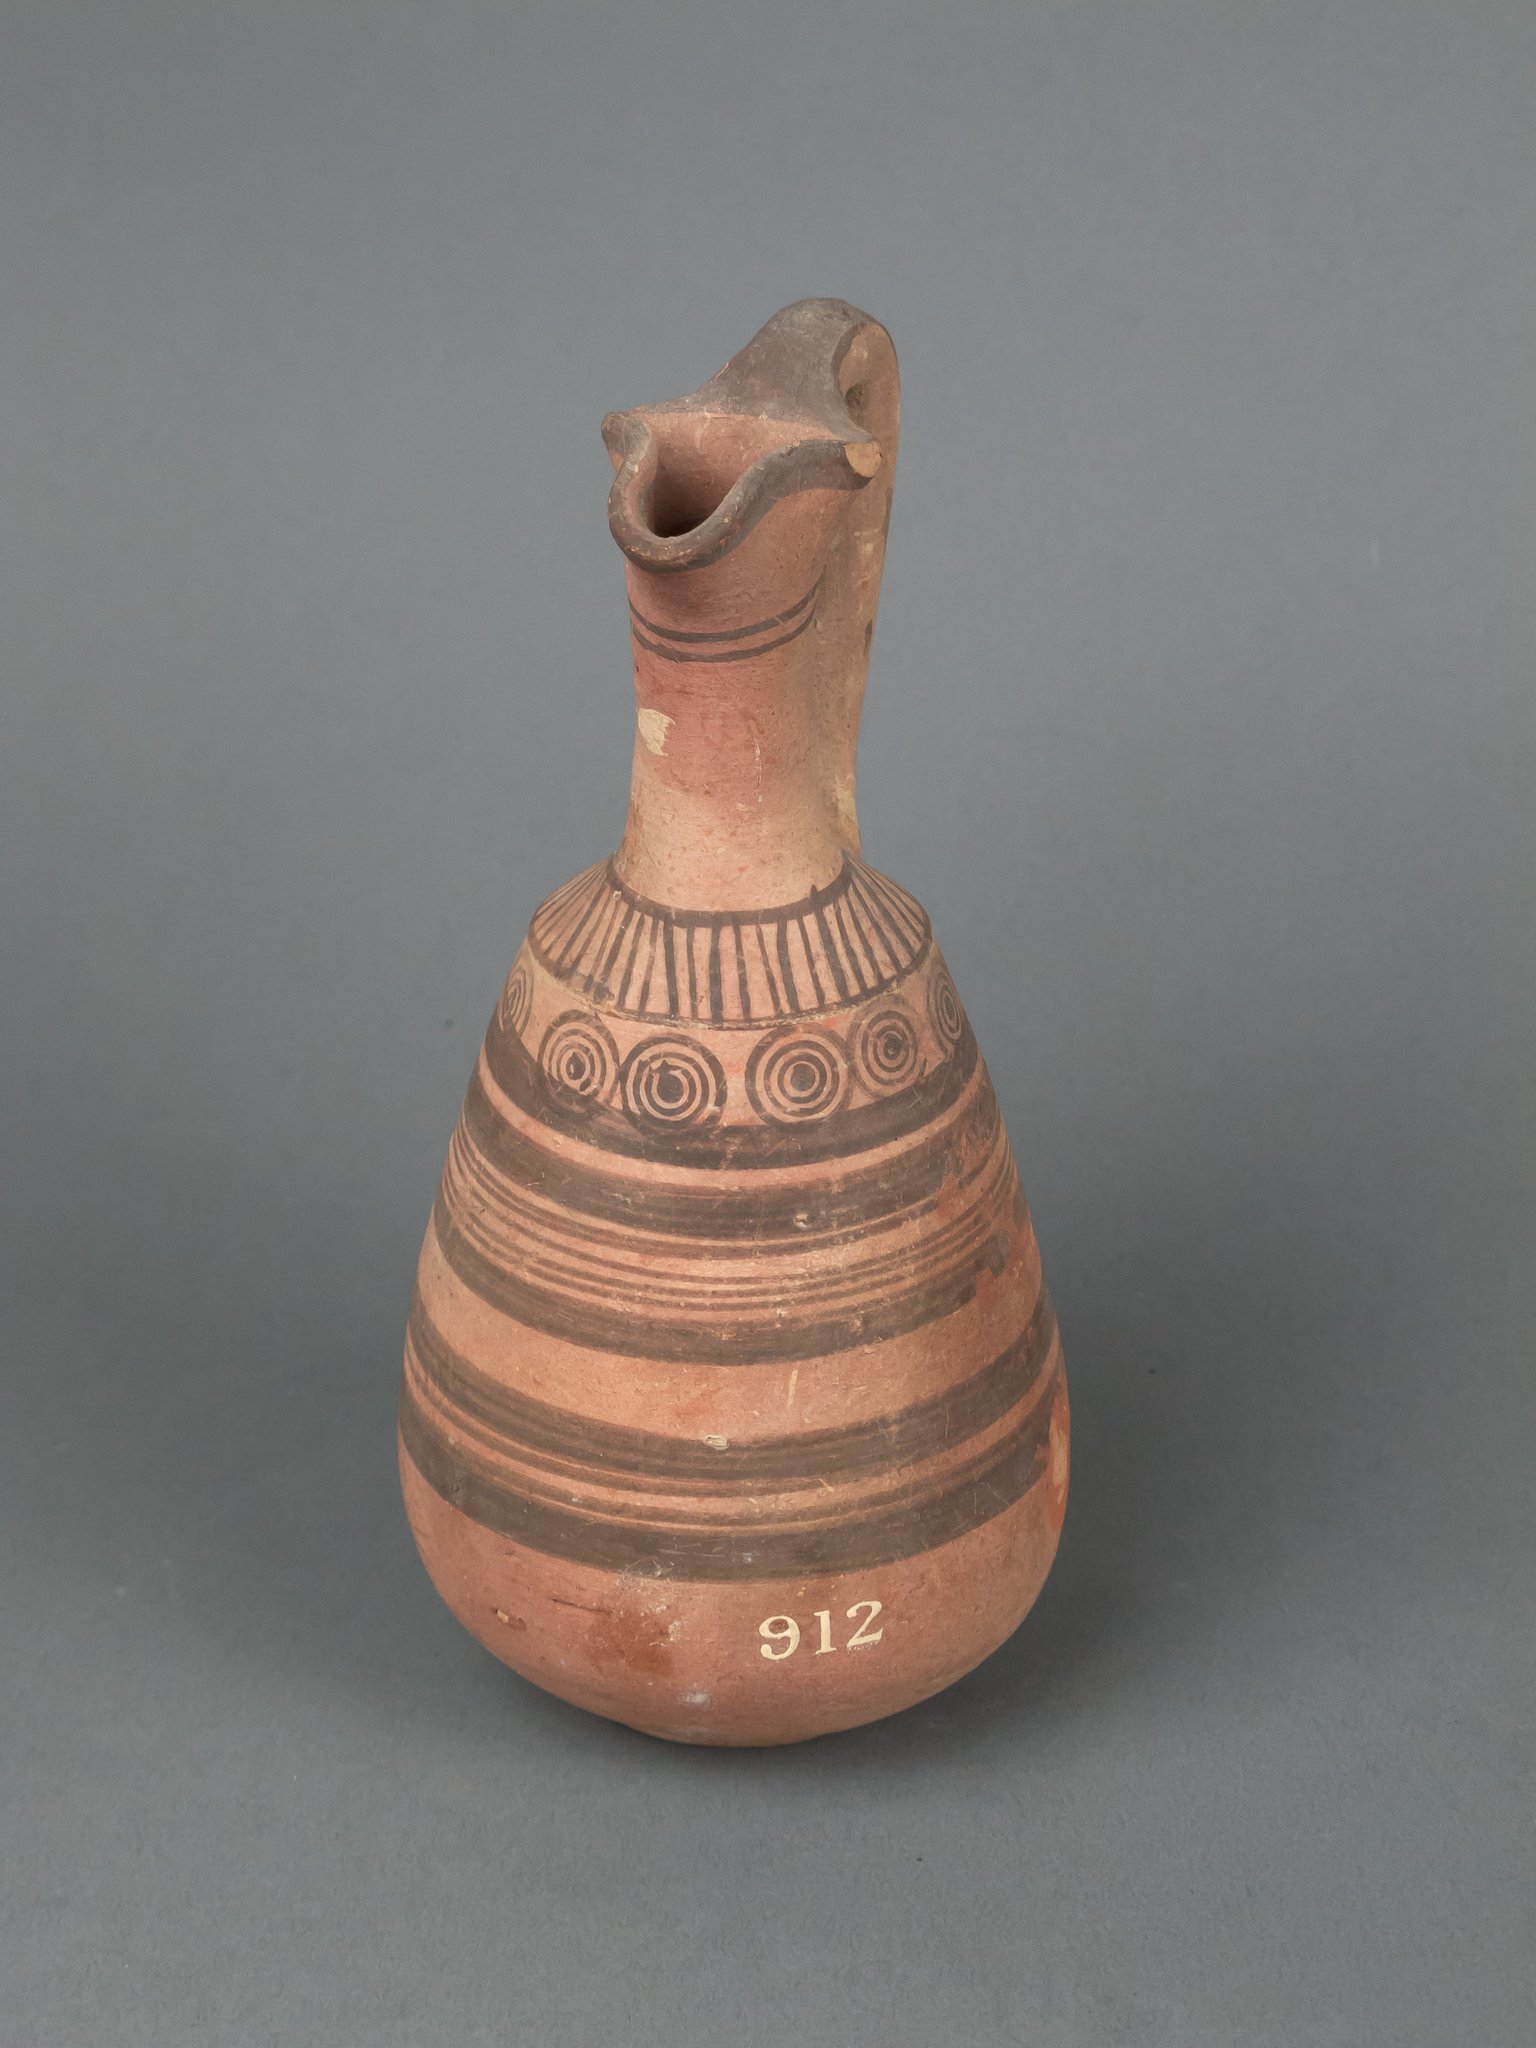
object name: juglet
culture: cypriot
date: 750-480 BCE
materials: terracotta